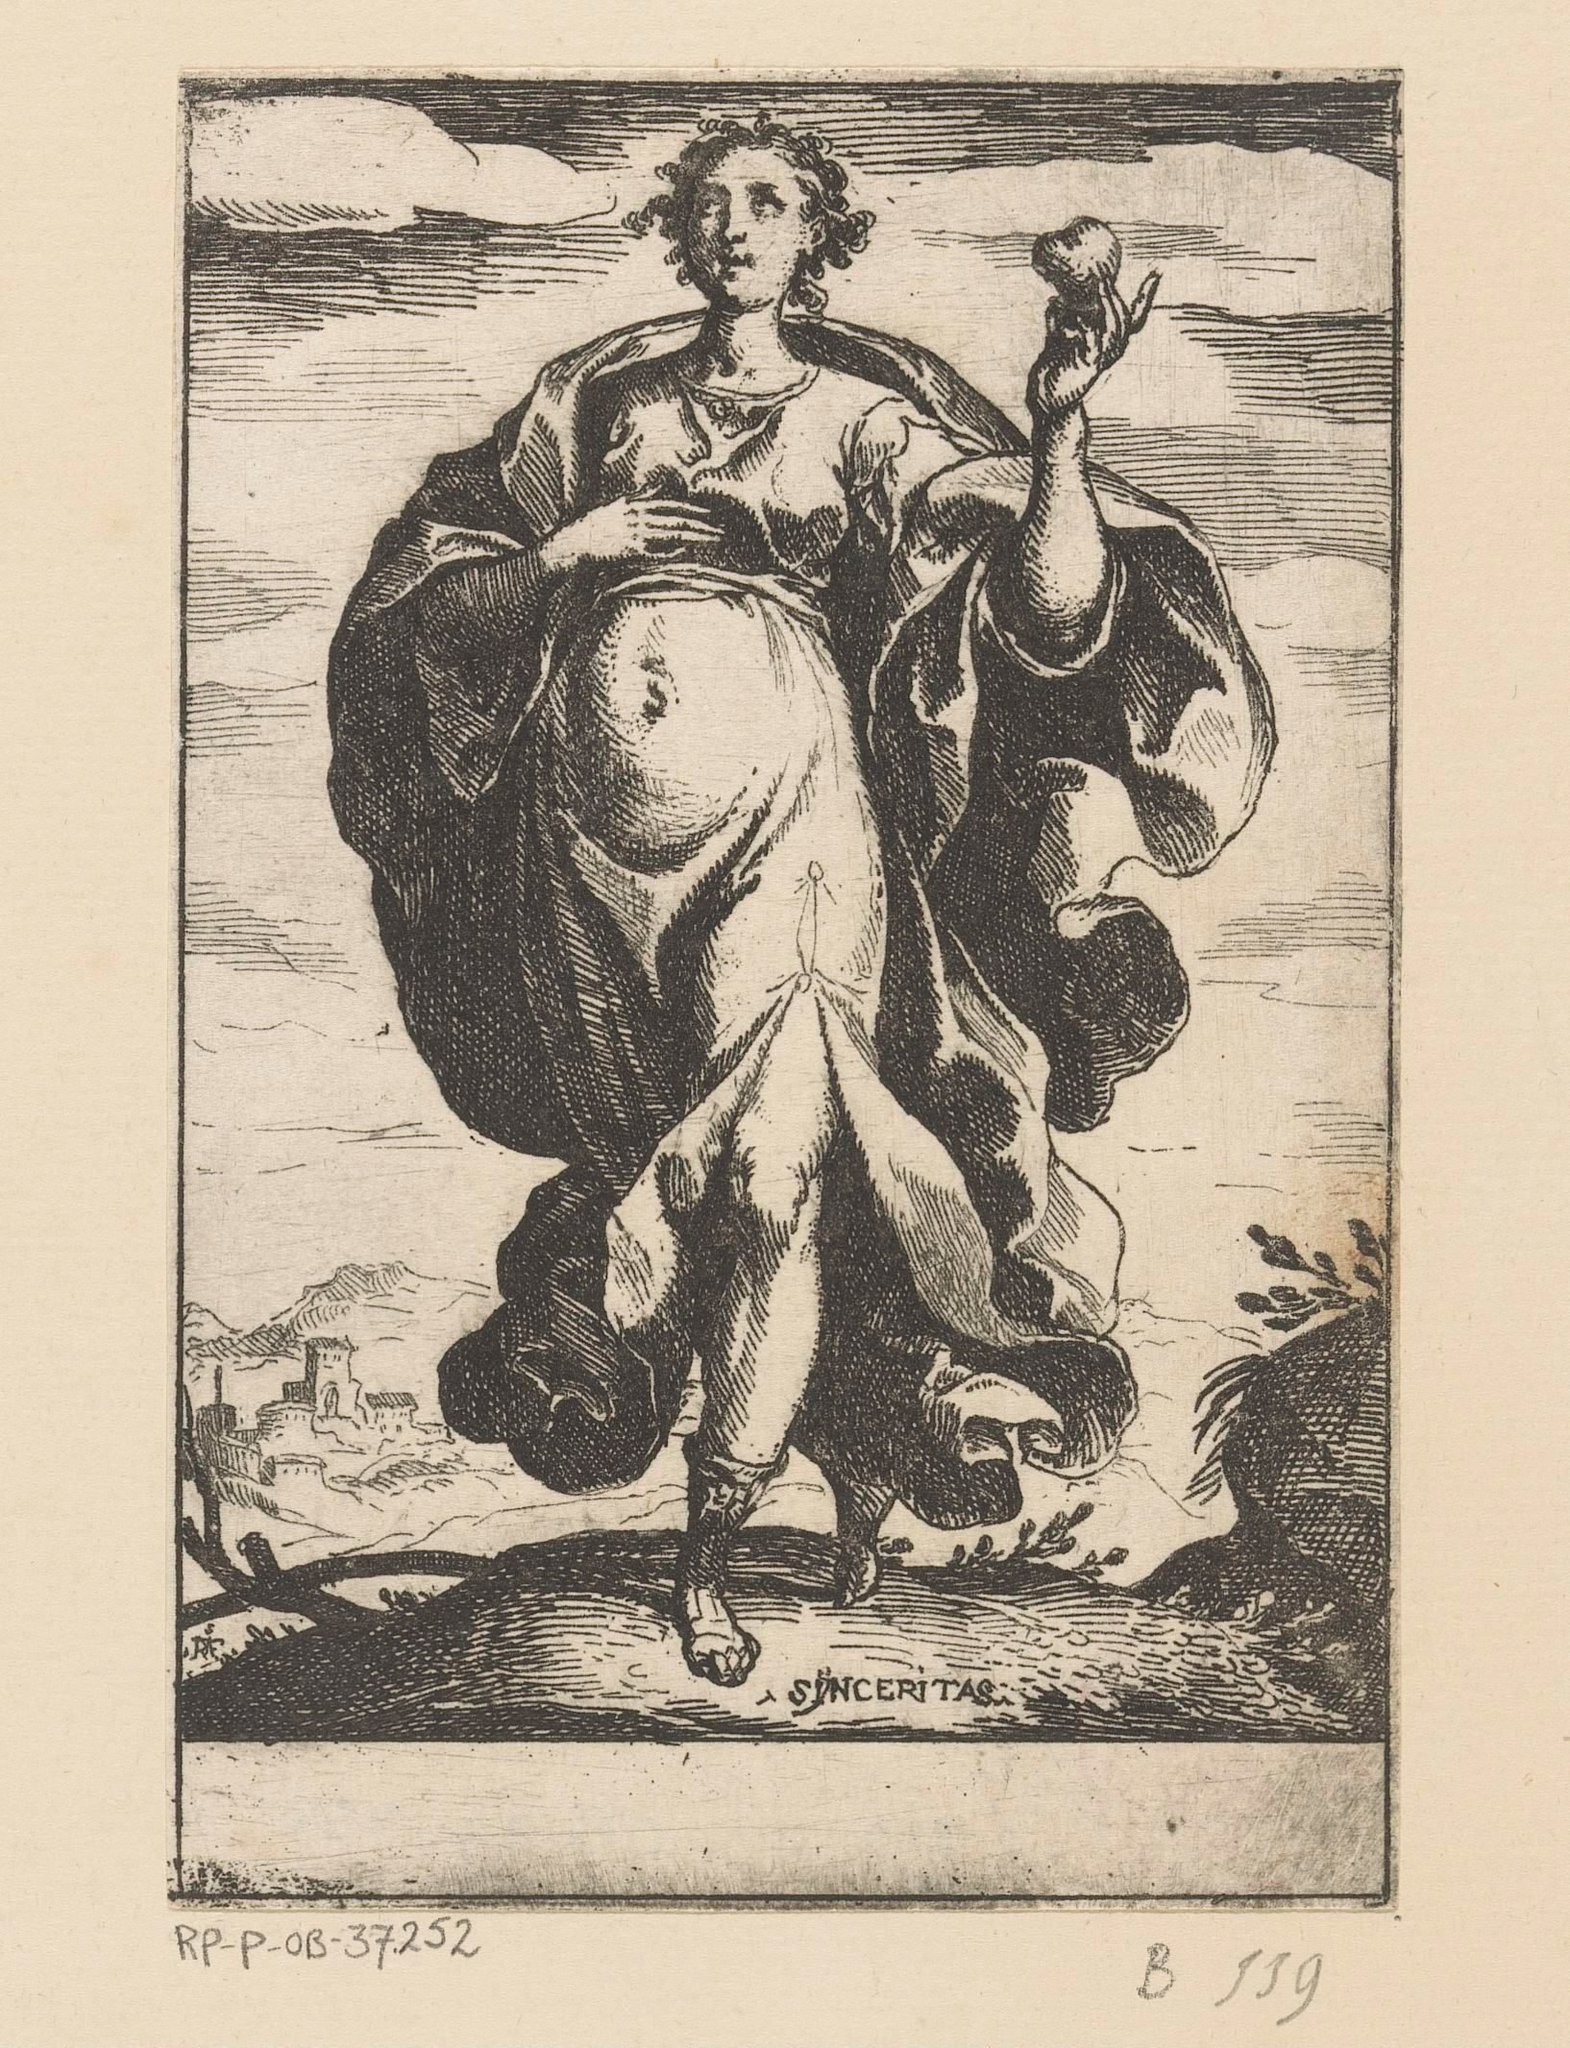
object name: print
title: Attributi dell'Anima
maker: raffaello schiaminossi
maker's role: painter, print maker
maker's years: 1572-1622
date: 1605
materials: paper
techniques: etching, intaglio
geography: italy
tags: city-view, and landscape with man-made constructions, heart - aa - female human figure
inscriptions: collector's mark: Lugt 240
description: Deze prent maakt deel uit van de serie 'Attributi dell'Anima', bestaande uit twaalf personificaties gedrukt van zes platen.